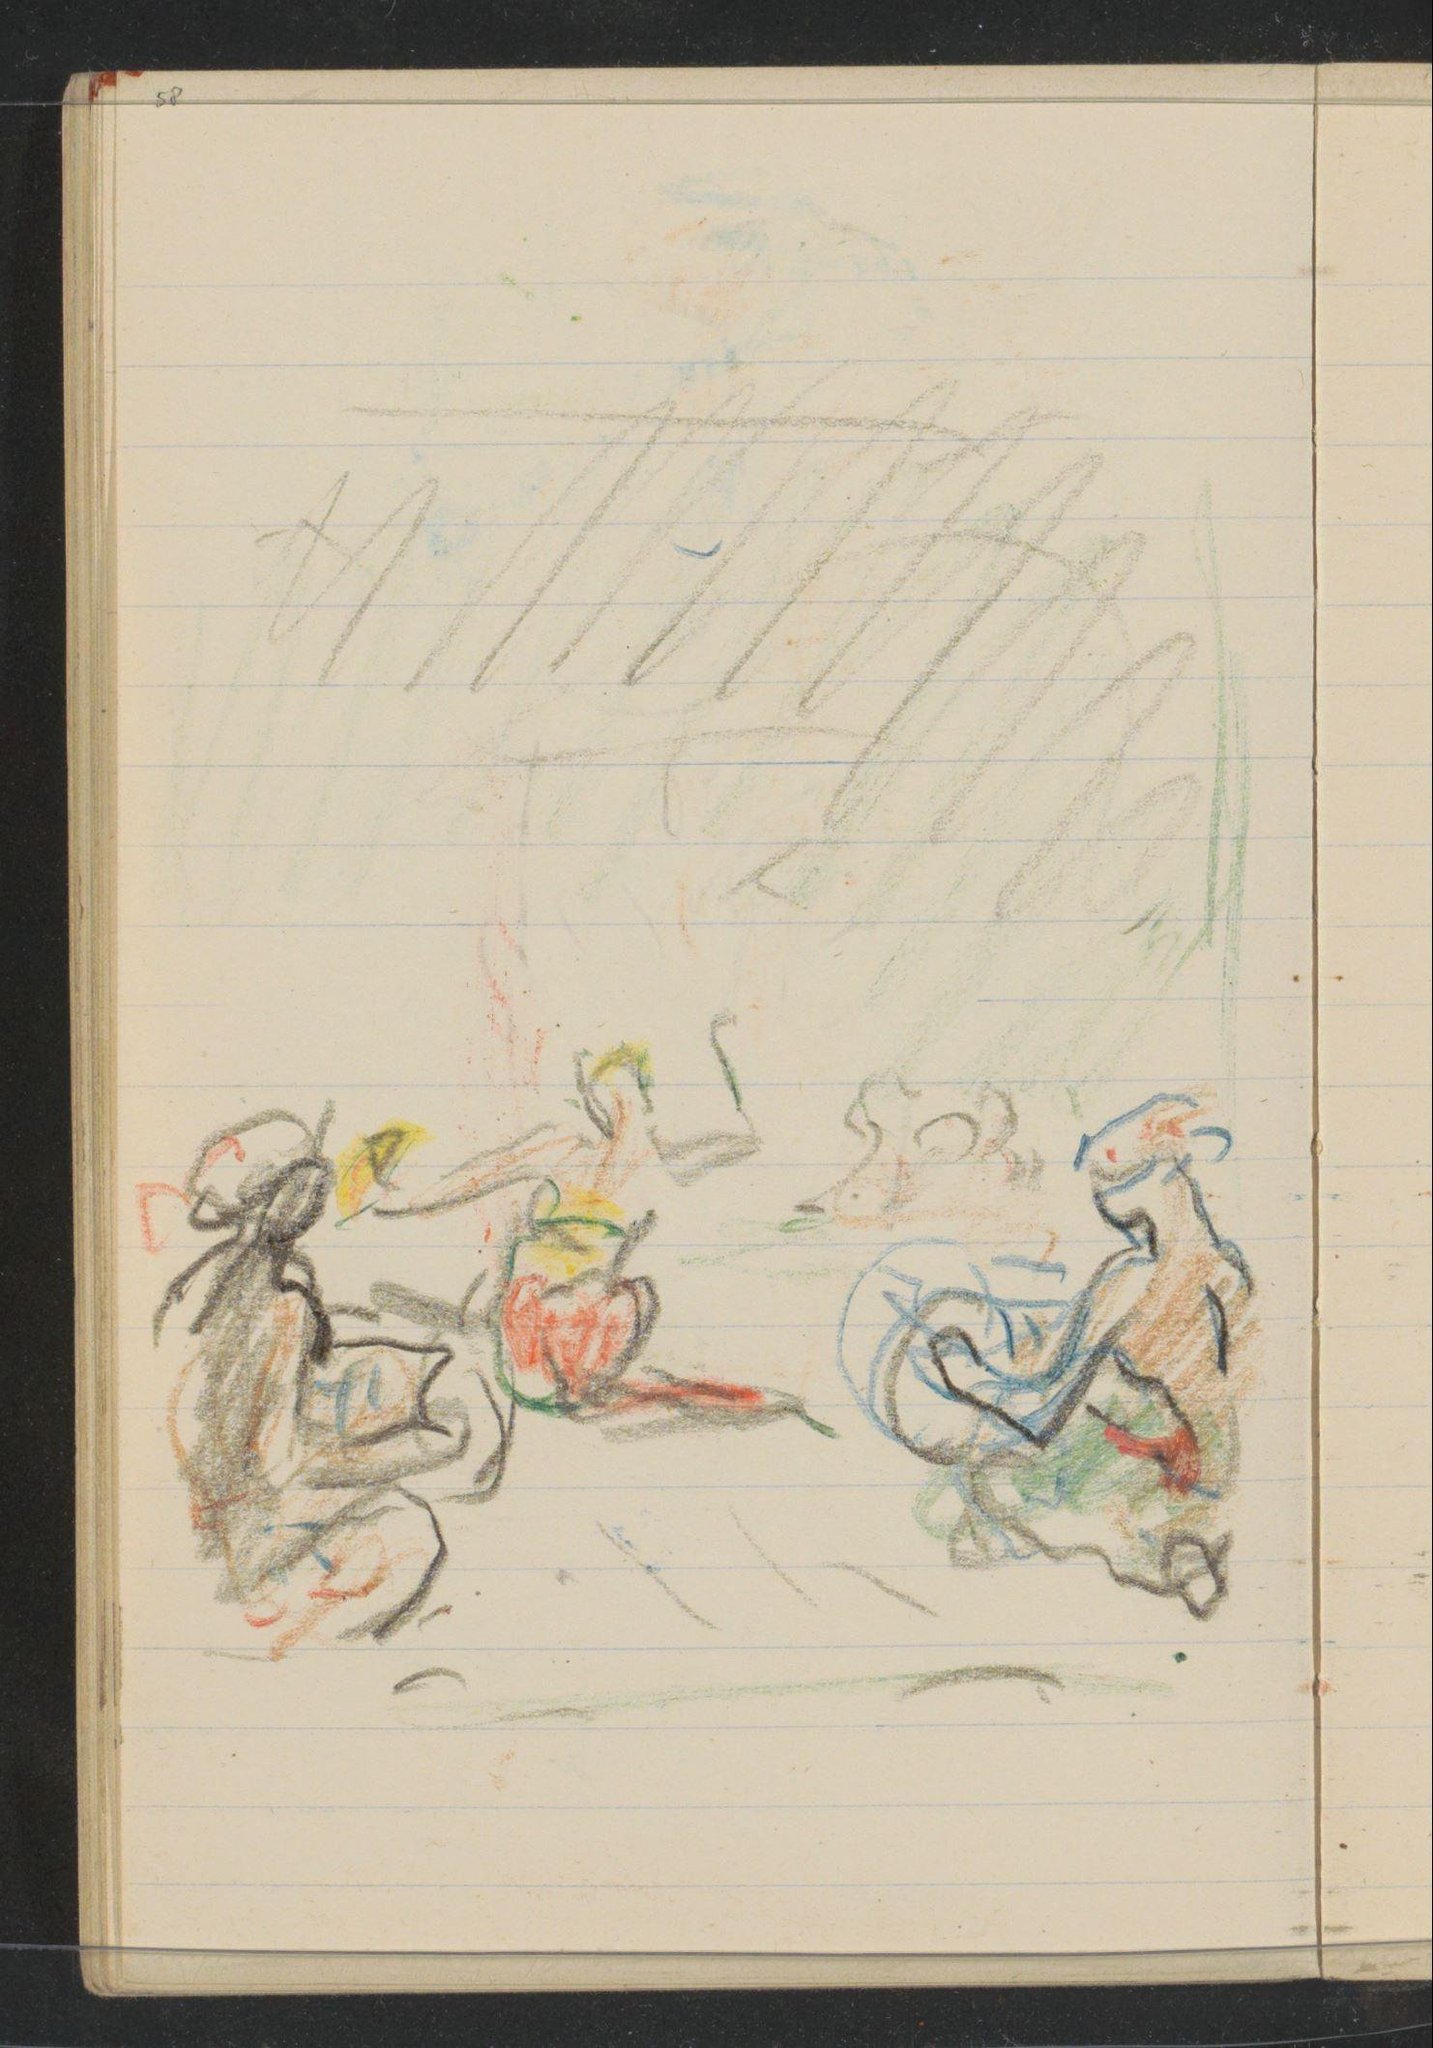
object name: sketchbook leaf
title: Gamelanorkest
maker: marius bauer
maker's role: draughtsman, print maker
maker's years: 1867-1932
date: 1931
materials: chalk, pencil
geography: bali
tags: small group of musicians, chamber orchestra, jazz band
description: Pagina 58 uit een schetsboek met 74 bladen.